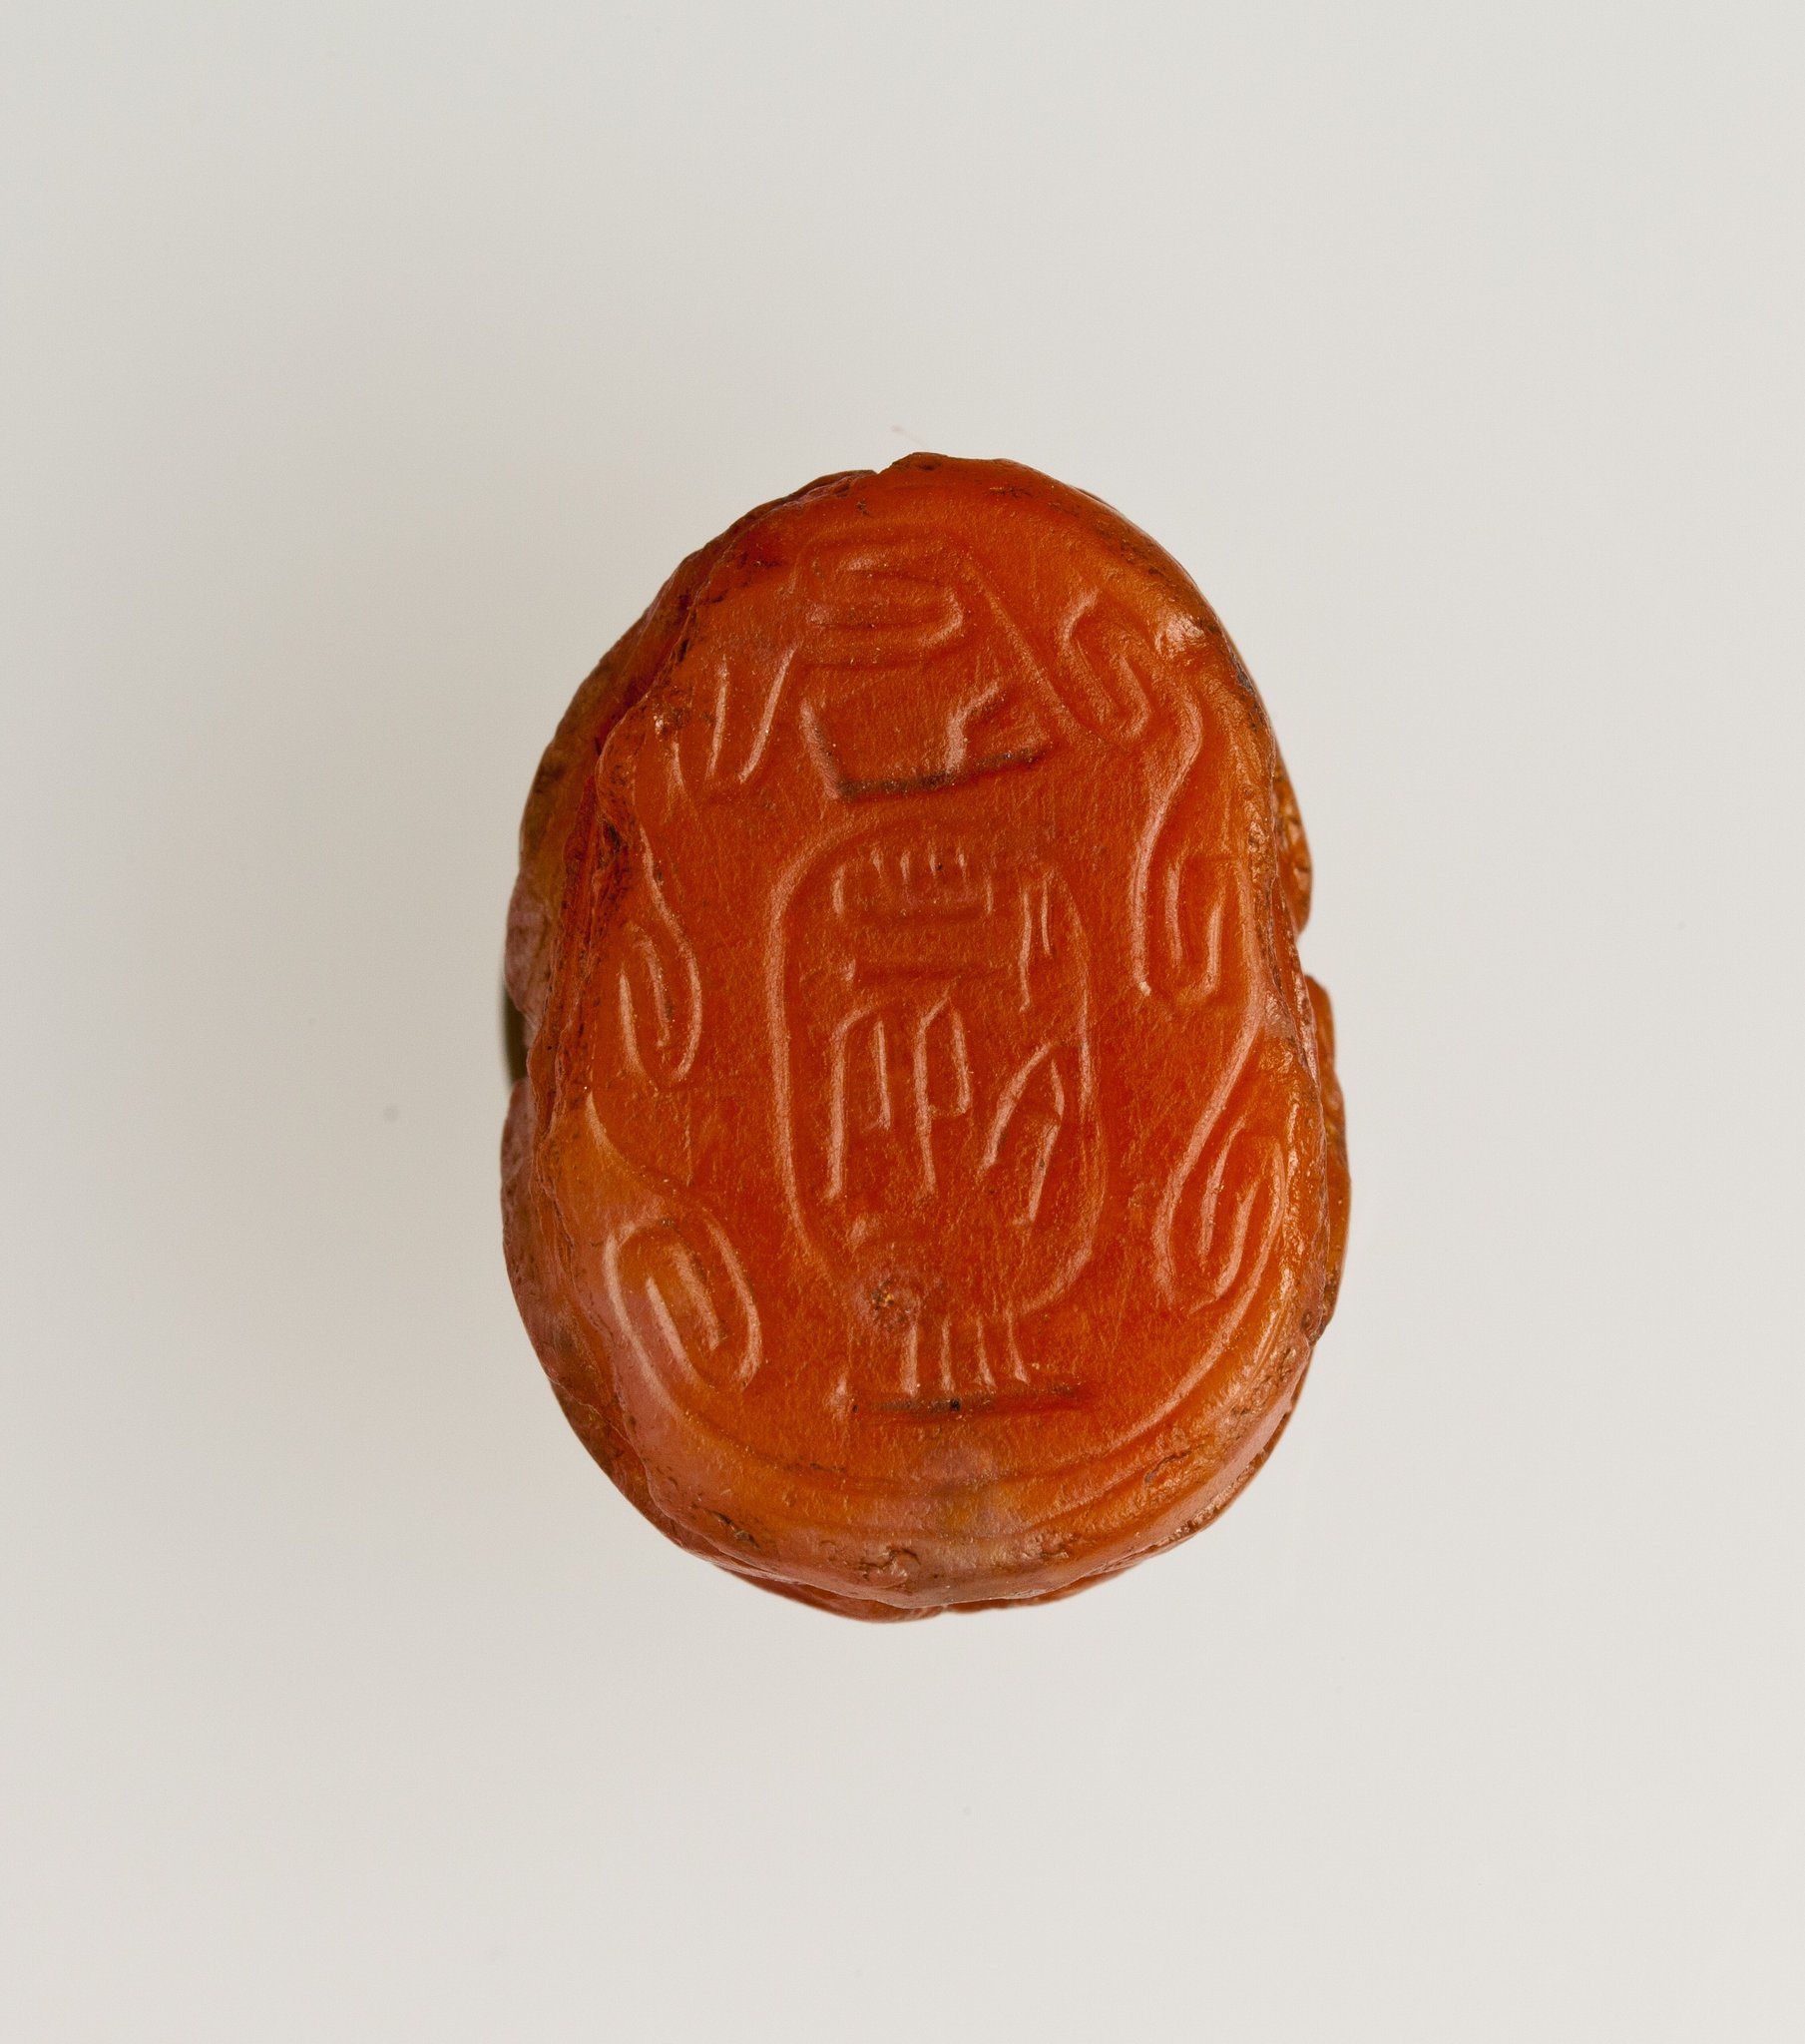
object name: scarab, merytamun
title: Scarab Inscribed for Merytamun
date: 1525-1504 BCE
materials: gemstone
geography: egypt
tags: hieroglyphs,scarabs